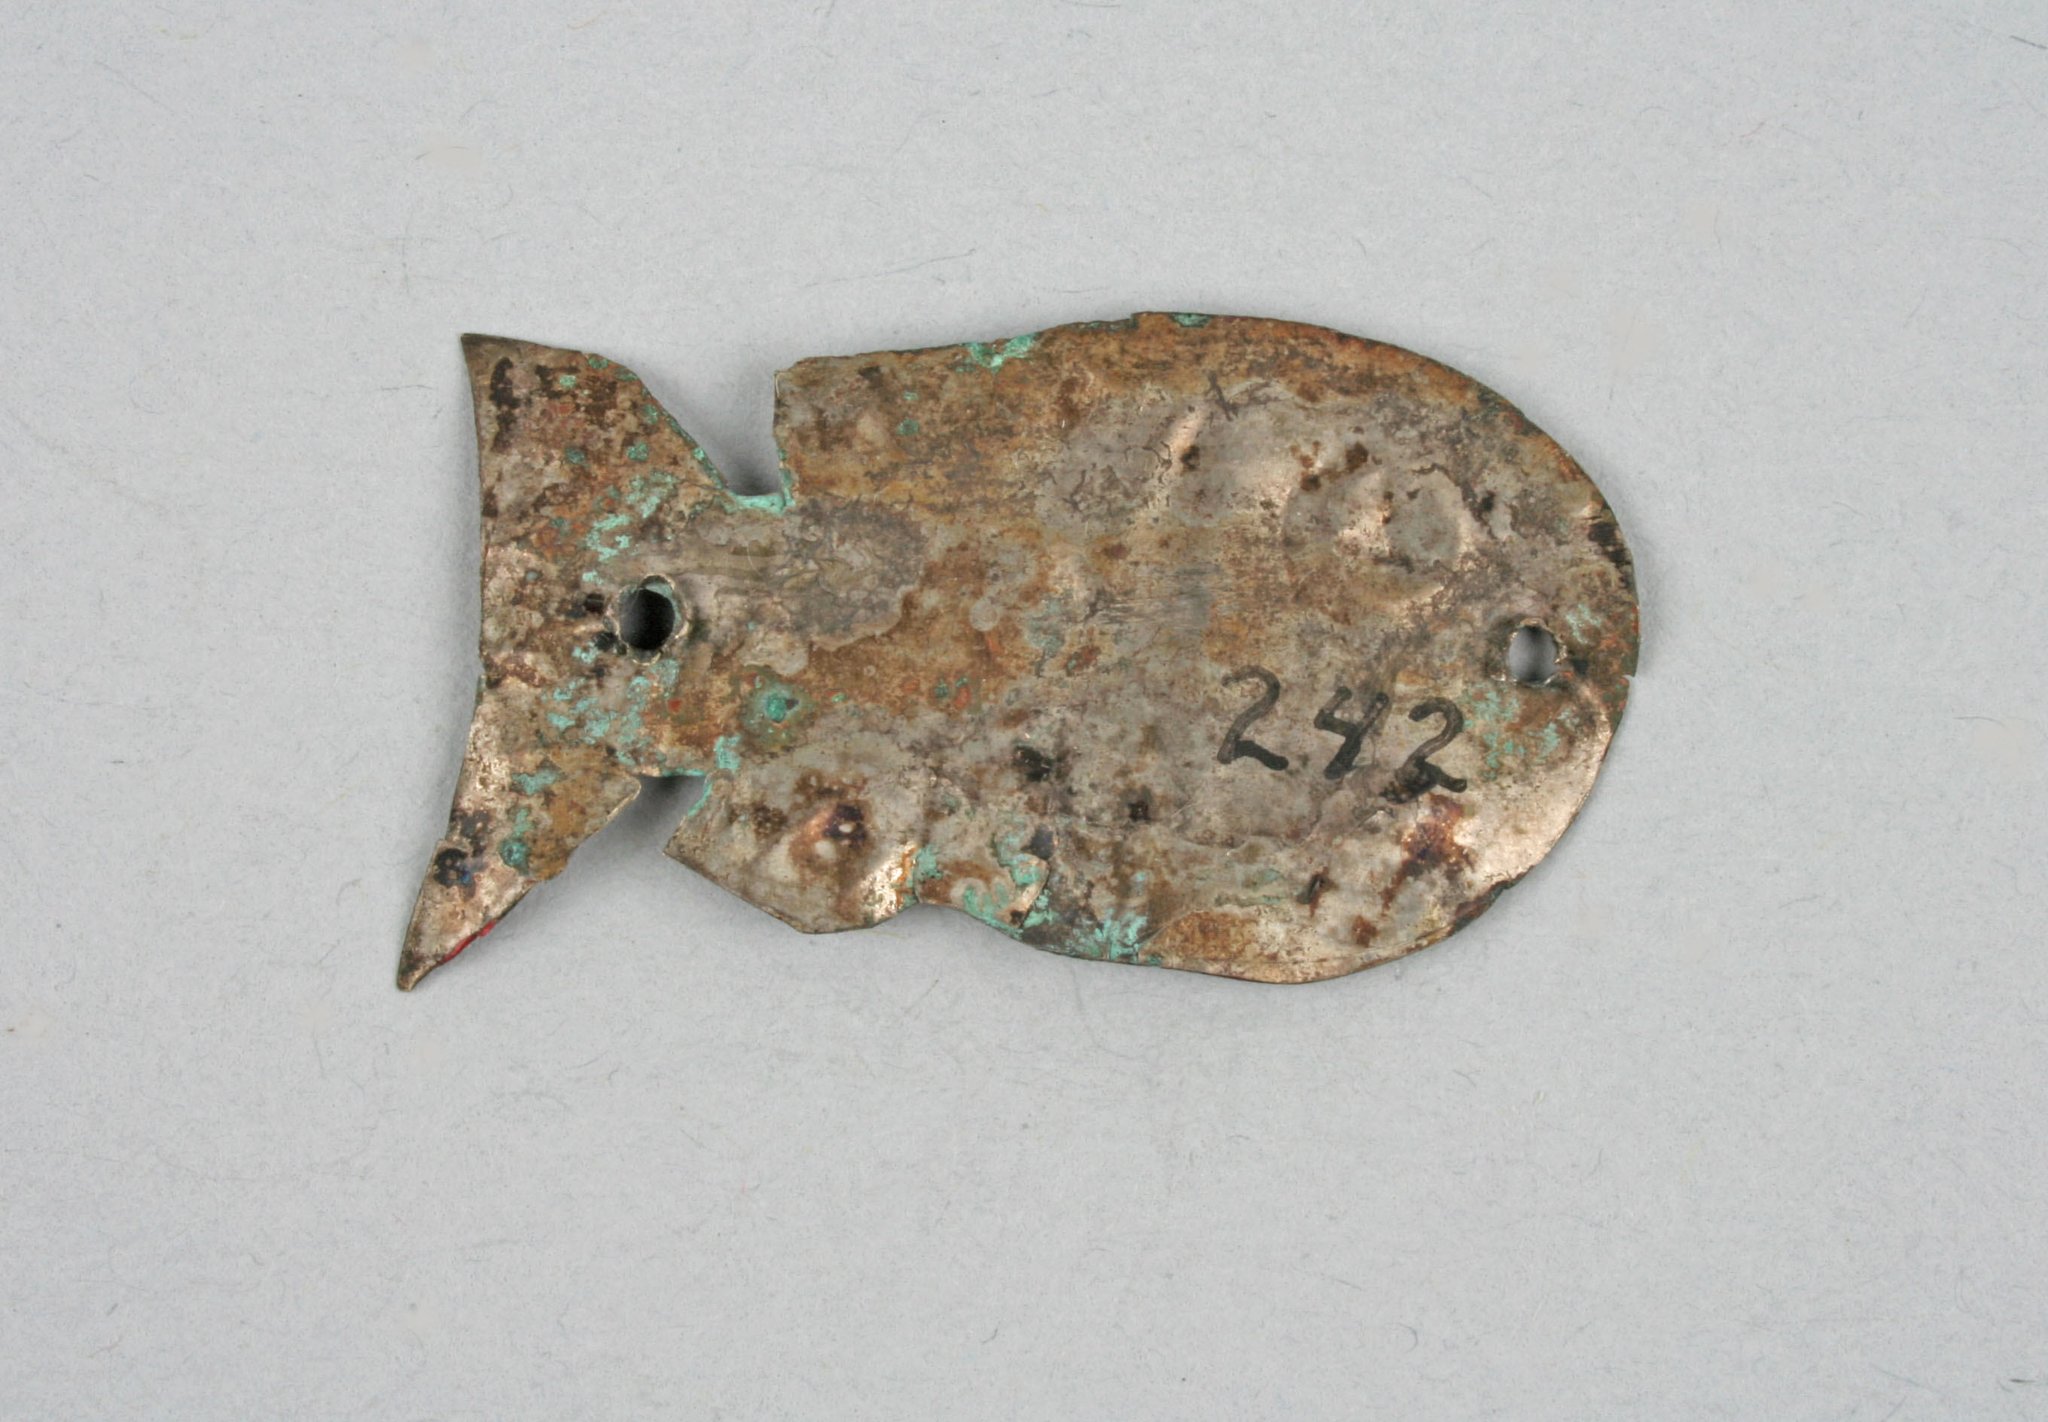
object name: ornament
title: Fish Ornament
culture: peruvian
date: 1001-1200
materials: silver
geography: peru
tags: fish